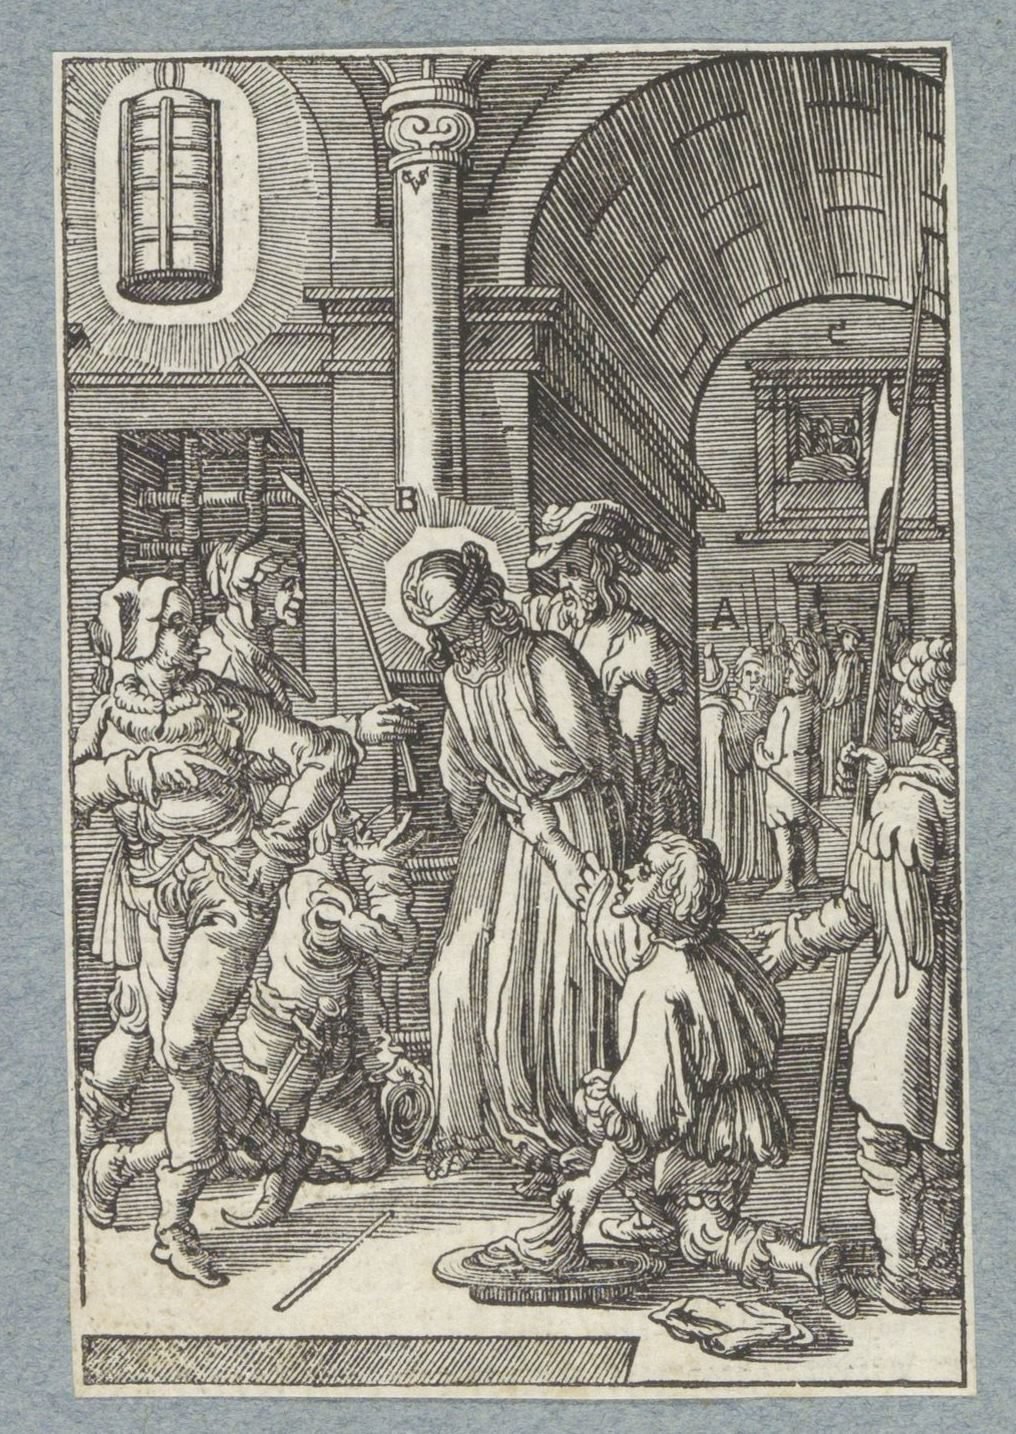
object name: print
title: Bespotting van Christus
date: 1629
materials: paper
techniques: letterpress printing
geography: antwerp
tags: in caiaphas' palace christ is mocked by jews (matthew 26:67-68; mark 14:65), flagellation by soldiers, christ usually tied to a column (matthew 27:26; mark 15:15; john 19:1)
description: De prent is afkomstig uit een van de uitgaven van P.J. Paets uit Amsterdam. De prent wordt voor het eerst gebruikt in: Der Zielen Lust-hof. Leuven, I.Jacbosz voor P.J. Paets [= Amsterdam, P.J. Paets], 1629. De voorstelling is gekopieerd naar een prent van Hieronymus Wierix voor: Nadal, Jerónimo. Evangelicae Historiae Imagines. Antwerpen, M. Nutius, 1593.